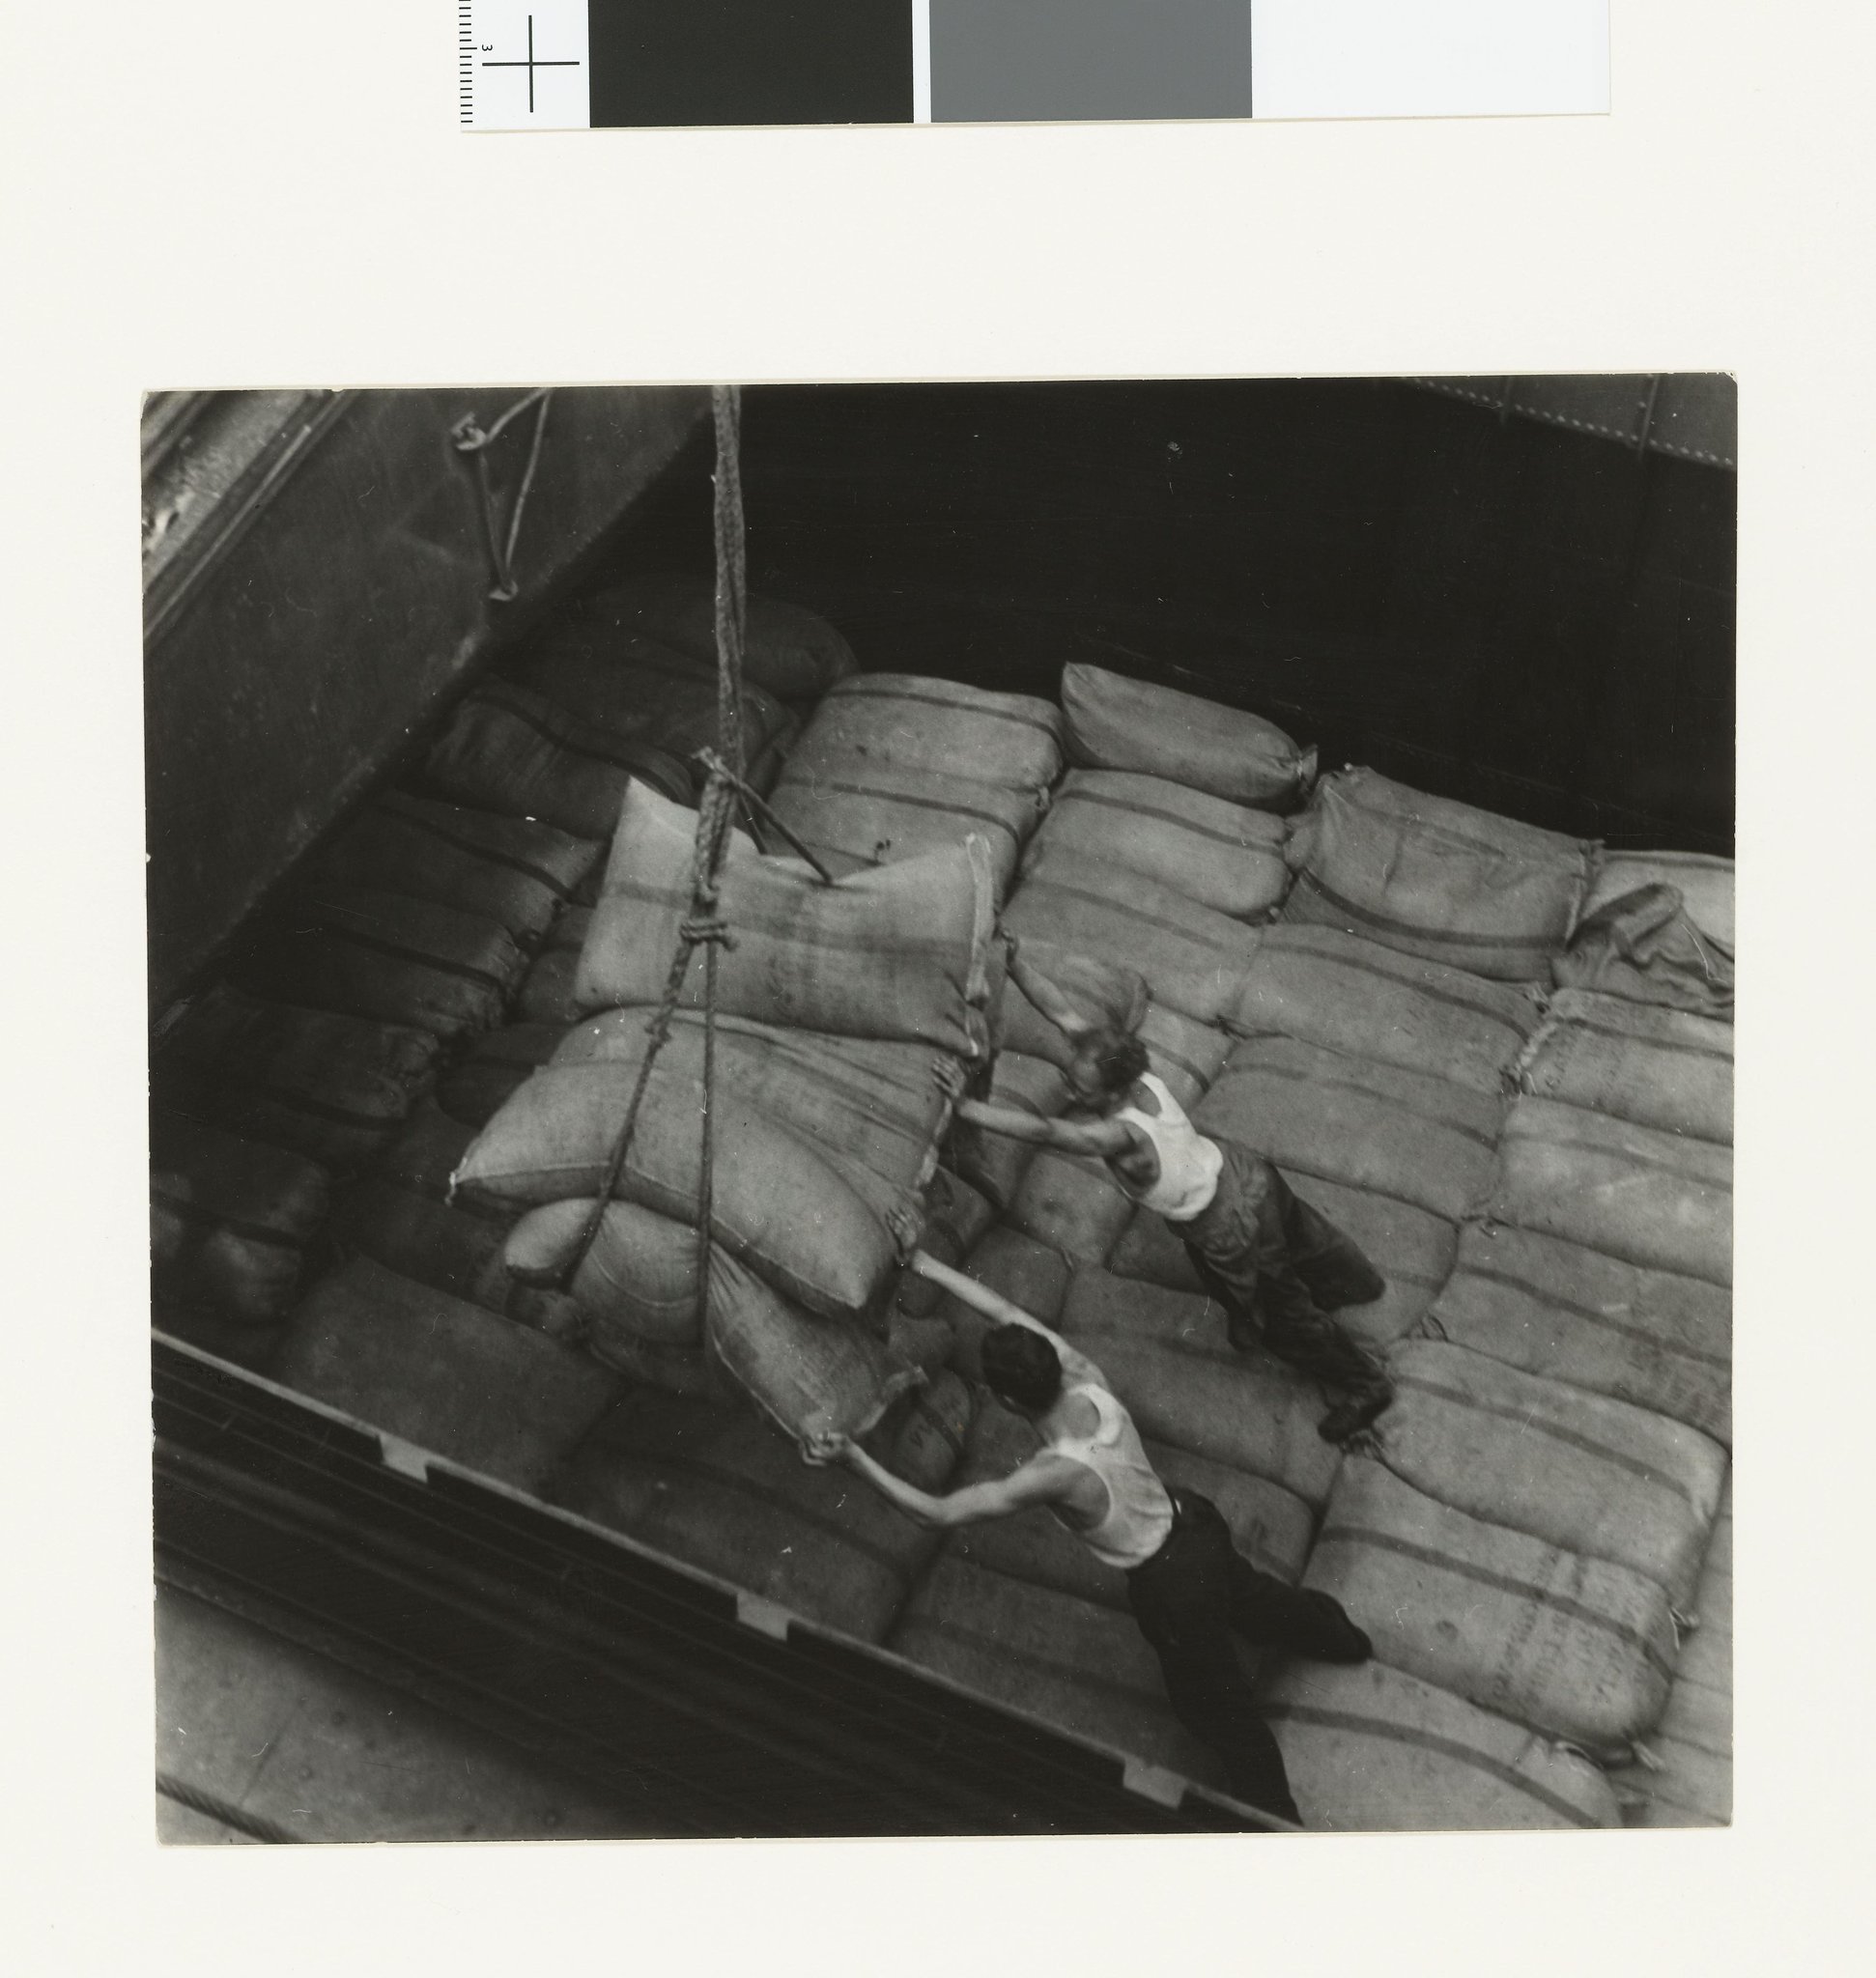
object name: documentary photograph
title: Twee havenarbeiders lossen een vrachtschip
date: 1940-1950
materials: photographic support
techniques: photography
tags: netherlands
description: Twee havenarbeiders, gekleed in broek en wit hemd, lossen een vrachtschip.